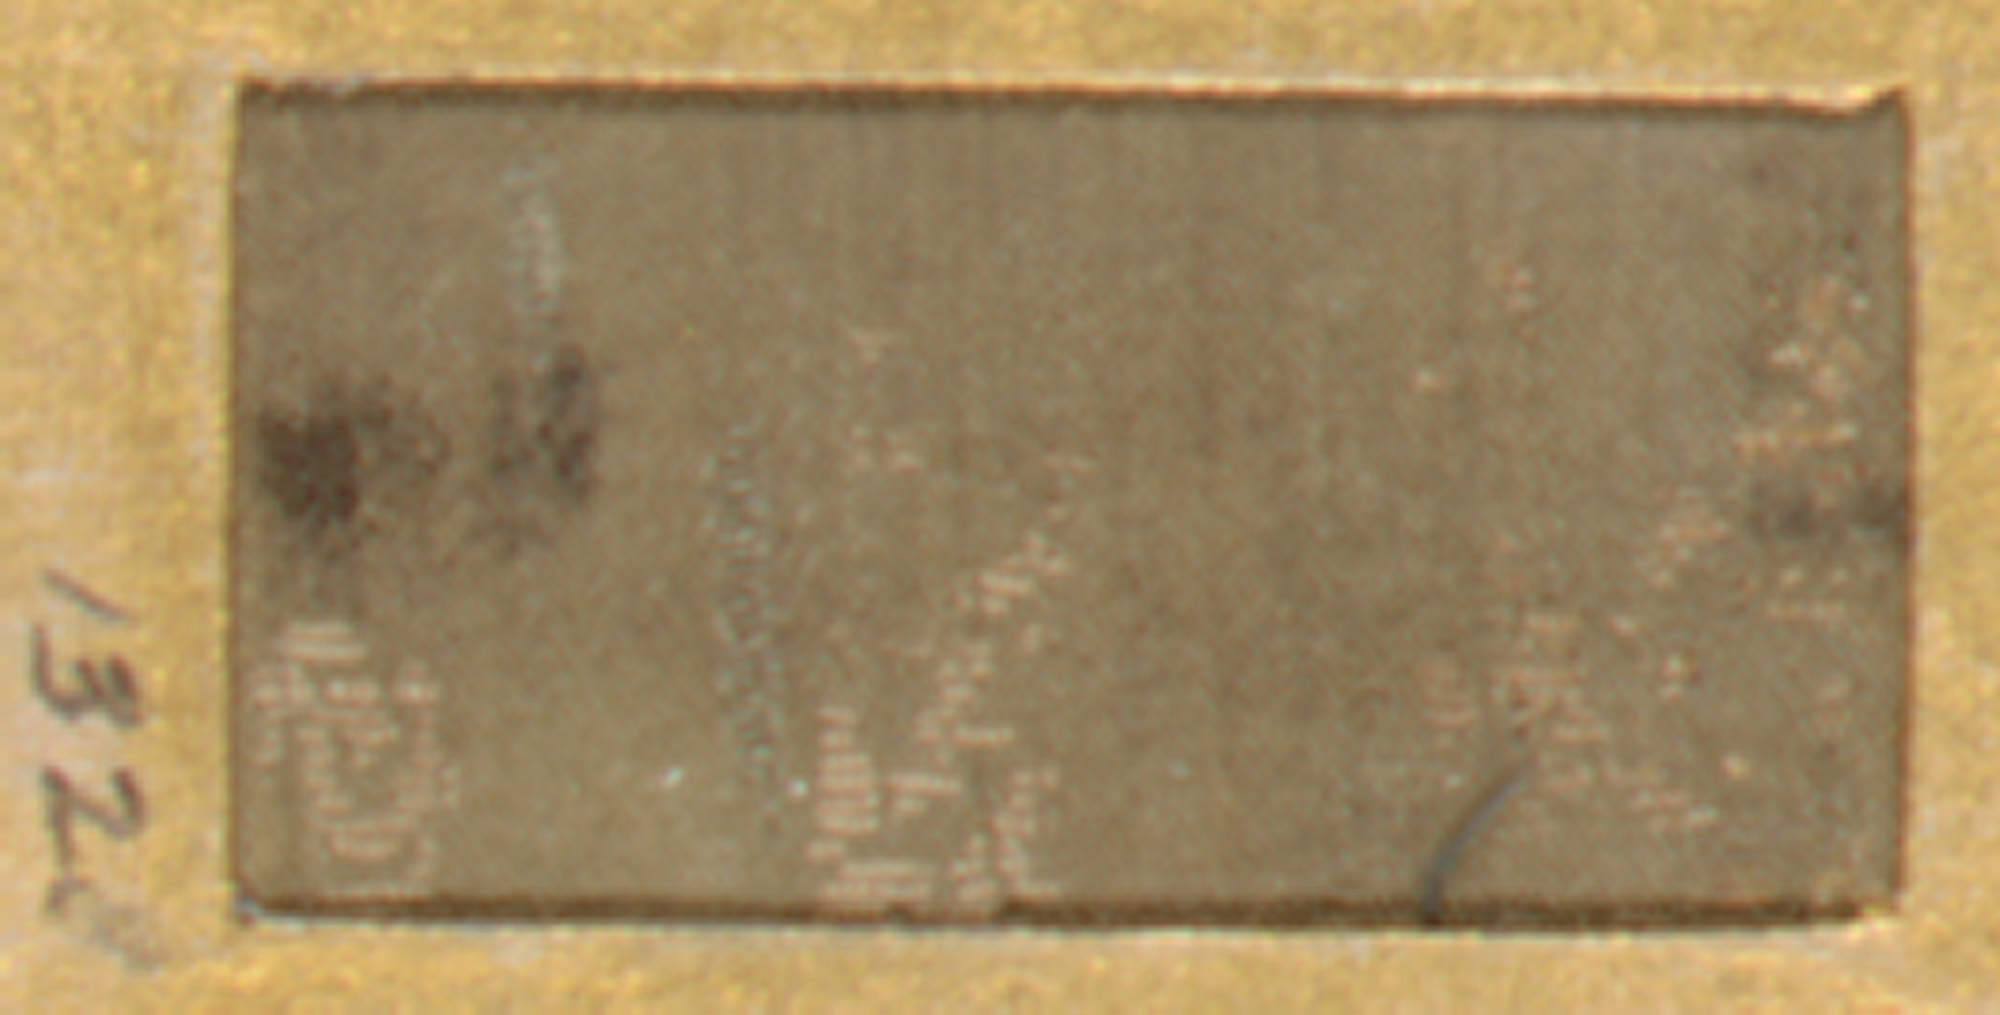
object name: piece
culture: japanese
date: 1701-1900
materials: silk